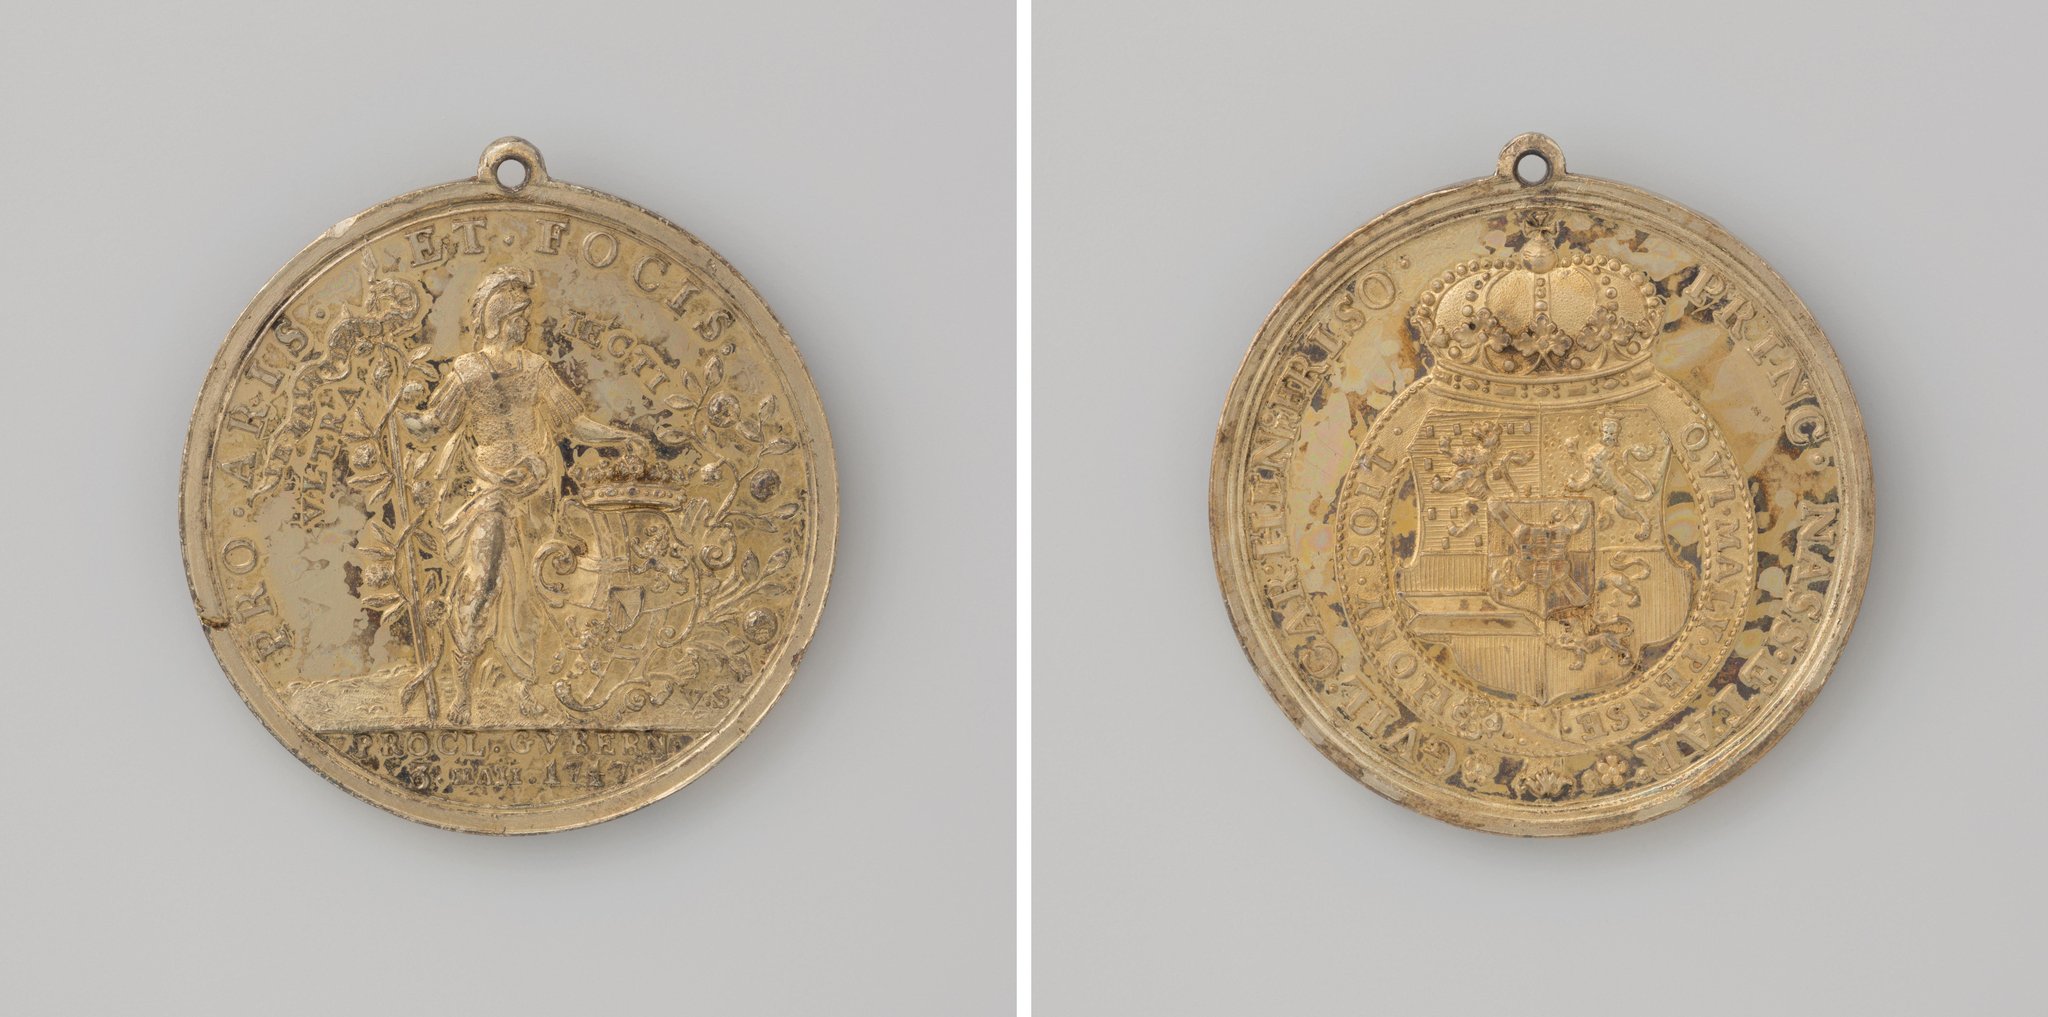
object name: history medal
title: Verheffing van de prins van Oranje tot stadhouder door de Staten van Utrecht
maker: nicolaas van swinderen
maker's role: jeweler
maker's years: 1705-1760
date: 1747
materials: silver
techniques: gilding, striking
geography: the hague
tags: willem iv (prins van oranje-nassau)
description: Zilveren penning met draagoog. Voorzijde: gehelmde Pallas met speer, omwonden met oranjeloof en wimpel met opschrift, houdt met linkerhand gekroond wapenschild, waarachter oranjeloof groeit binnen omschrift; afsnede: opschrift. Keerzijde: gekroond wapenschild, omhangen met orde van kouseband binnen omschrift